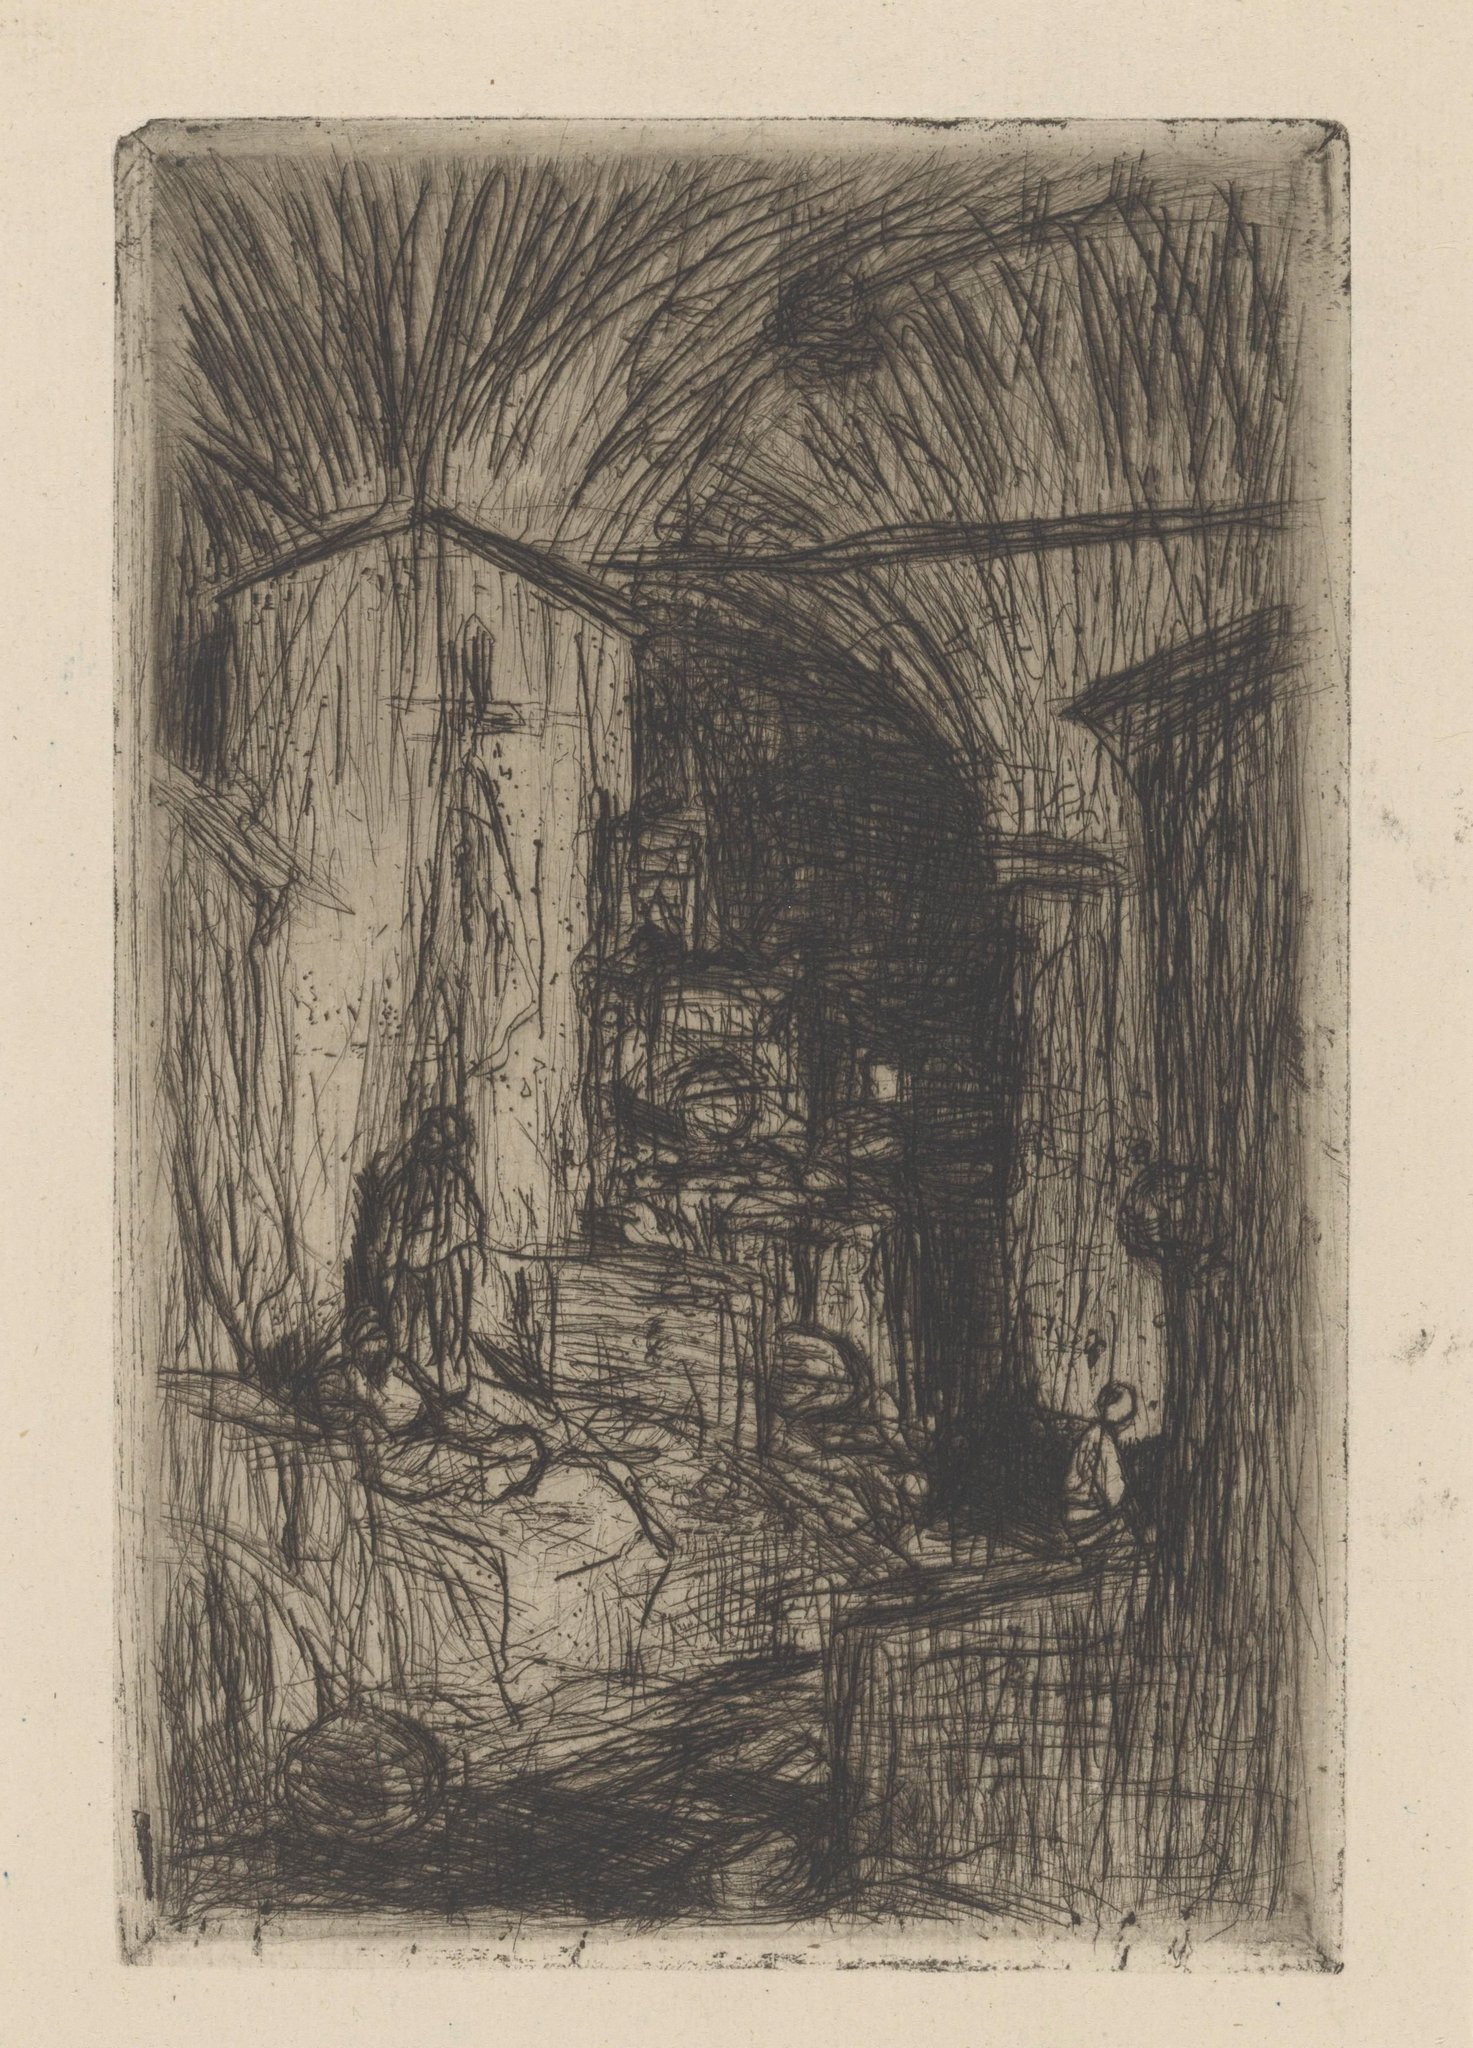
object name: print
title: Ottomaanse bazaar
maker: marius bauer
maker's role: draughtsman, print maker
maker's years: 1867-1932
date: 1889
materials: paper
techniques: etching, intaglio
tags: market-hall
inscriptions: collector's mark: Lugt 2228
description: Een overdekte bazaar met drie figuren, waarvan twee zittend en één staand.